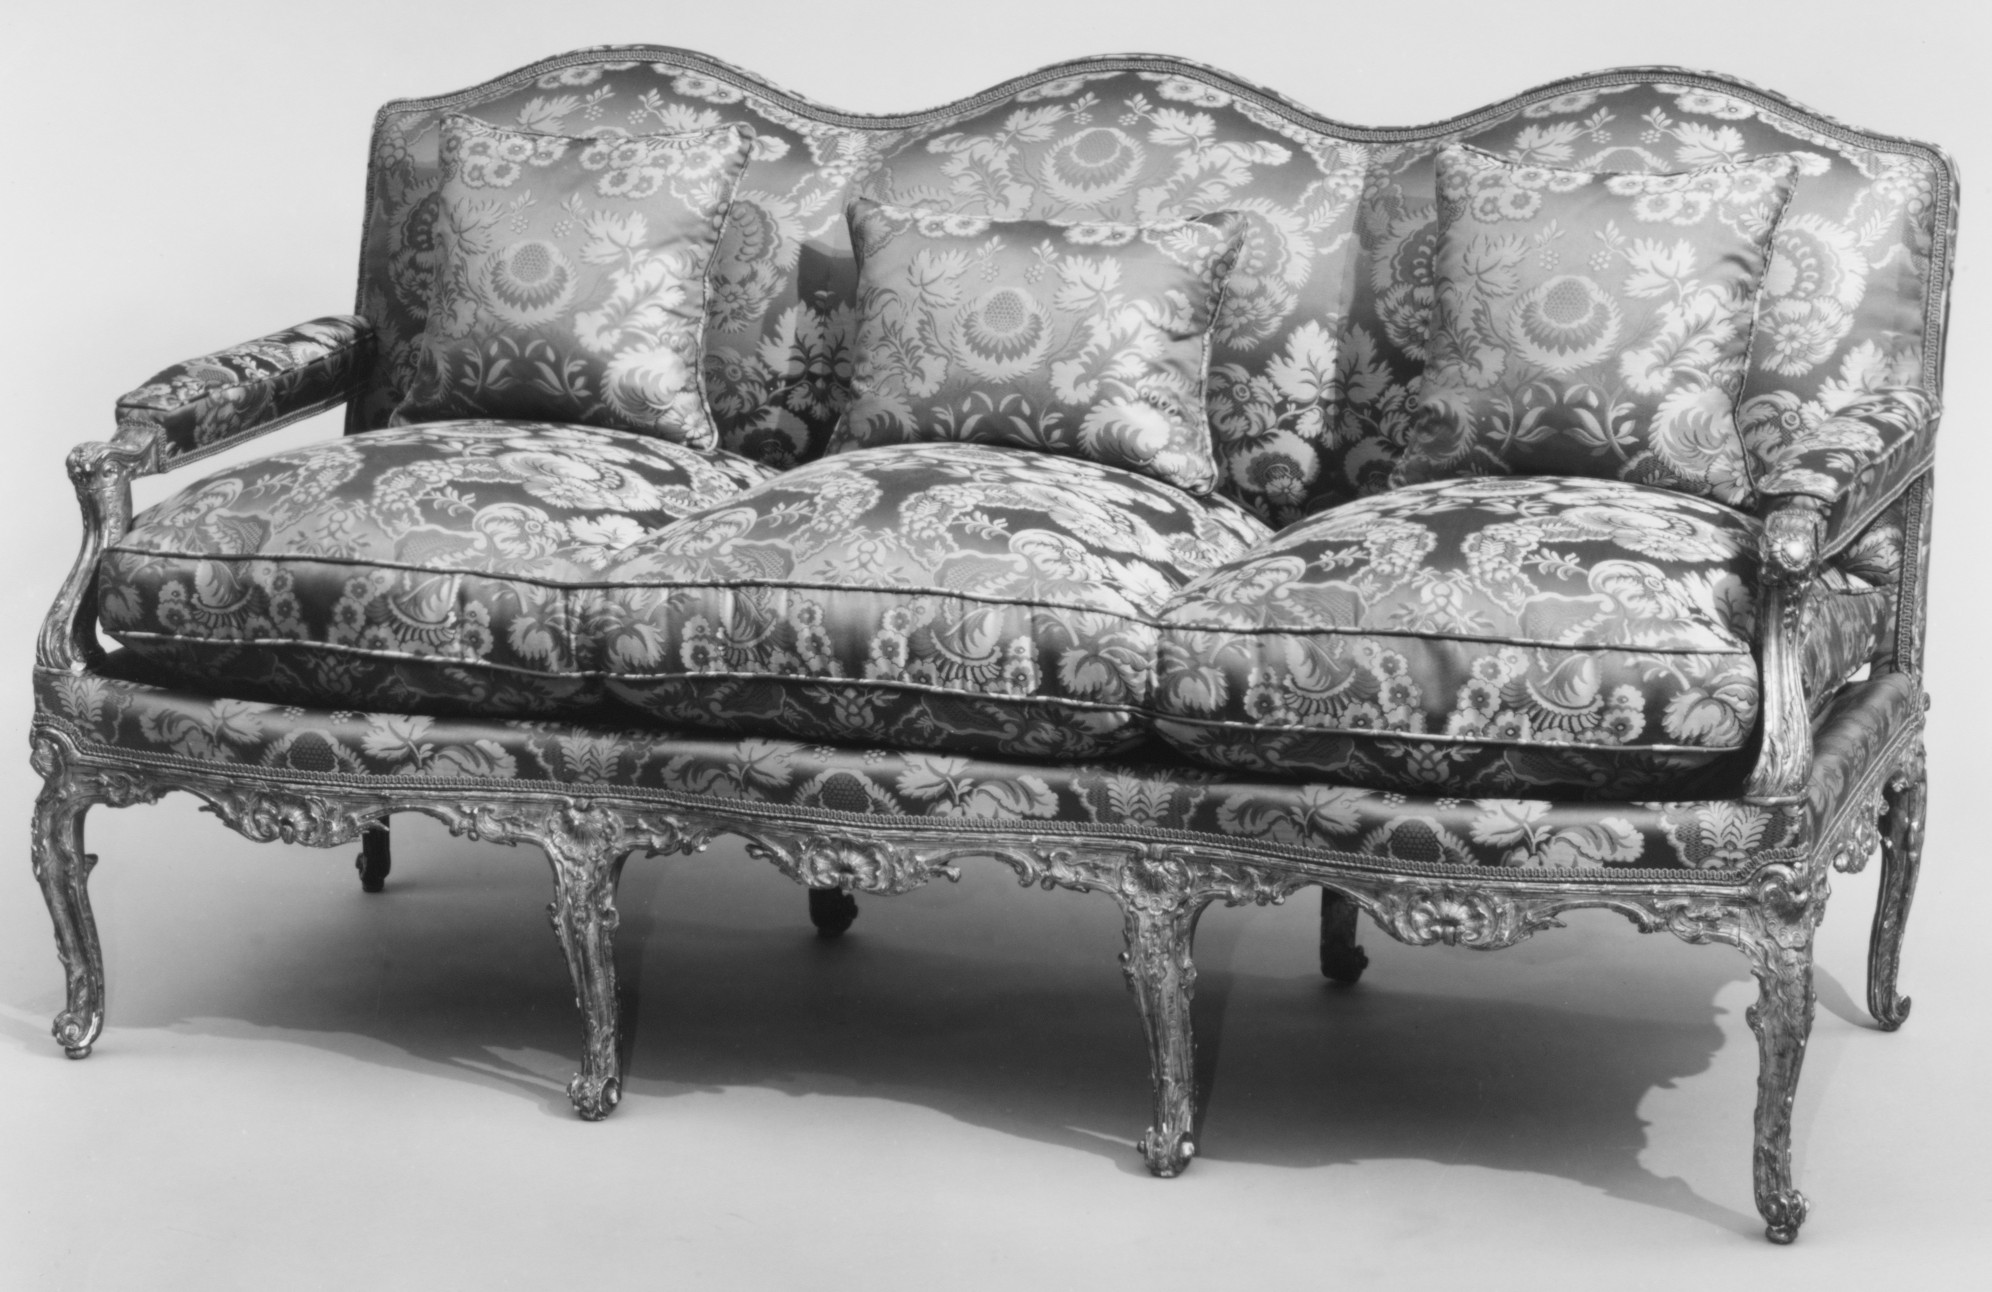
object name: sofa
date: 1730-1735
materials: wood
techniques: carving, damask, gilding